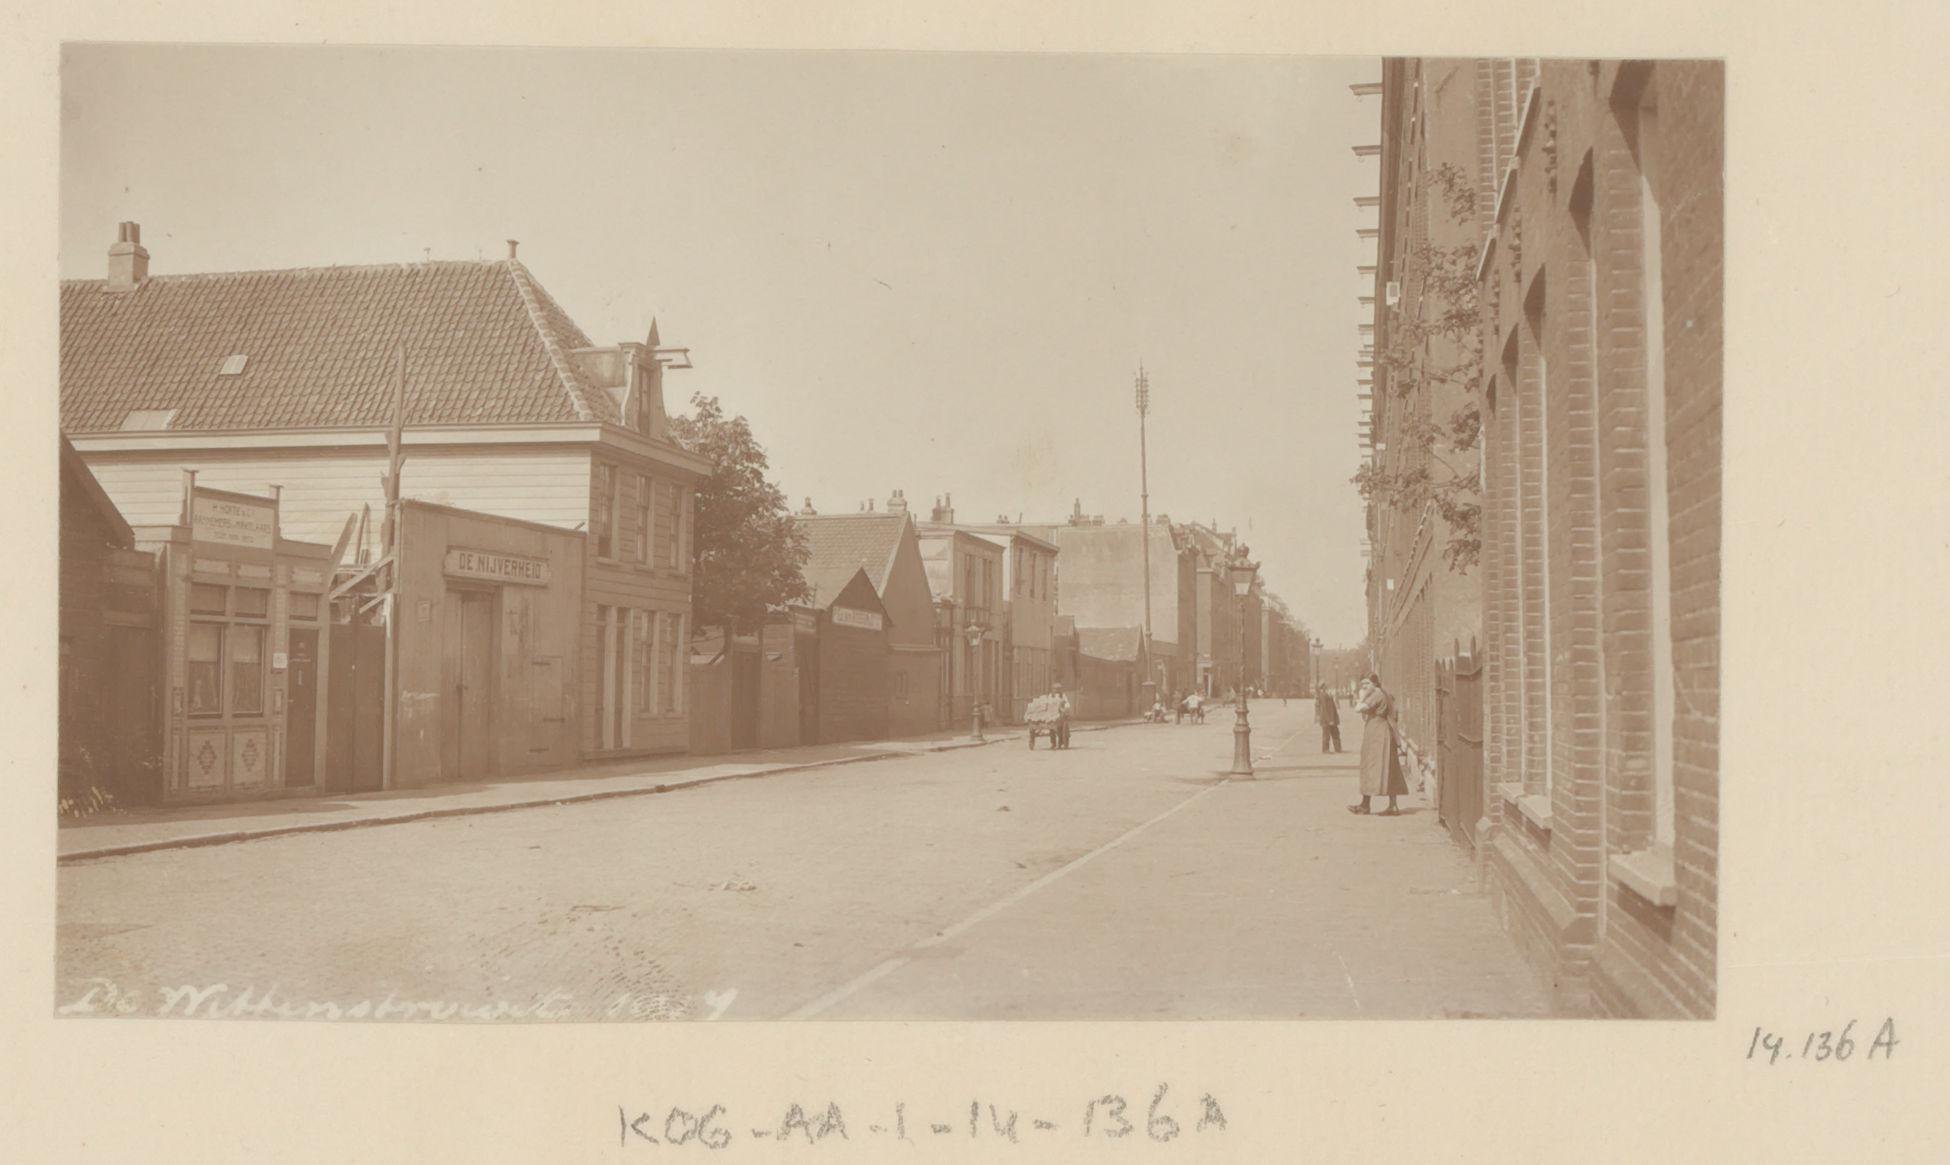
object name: photograph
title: Gezicht op de De Wittenstraat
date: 1917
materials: cardboard, paper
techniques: albumen print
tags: city-view in general; 'veduta', the usual house or row of houses, street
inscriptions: inscription: ‘De Wittenstraat / in 1917. / April 1920. / Geschenk v/d Heer J. van Eck.’, collector's mark: ‘14 136AB’ Lugt 1641b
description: Onderwerpsrubriek binnen de Atlas Amsterdam: Waal (Kromme en Oude), Walenpleintje, Warmoesgracht, Warmoesstraat, Waterlooplein, Westerdoksdijk, Westermarkt, Weteringschans, Willemspark, Willemsstraat, Wittenburg, Wittenkade (de), Wittenstraat (de).